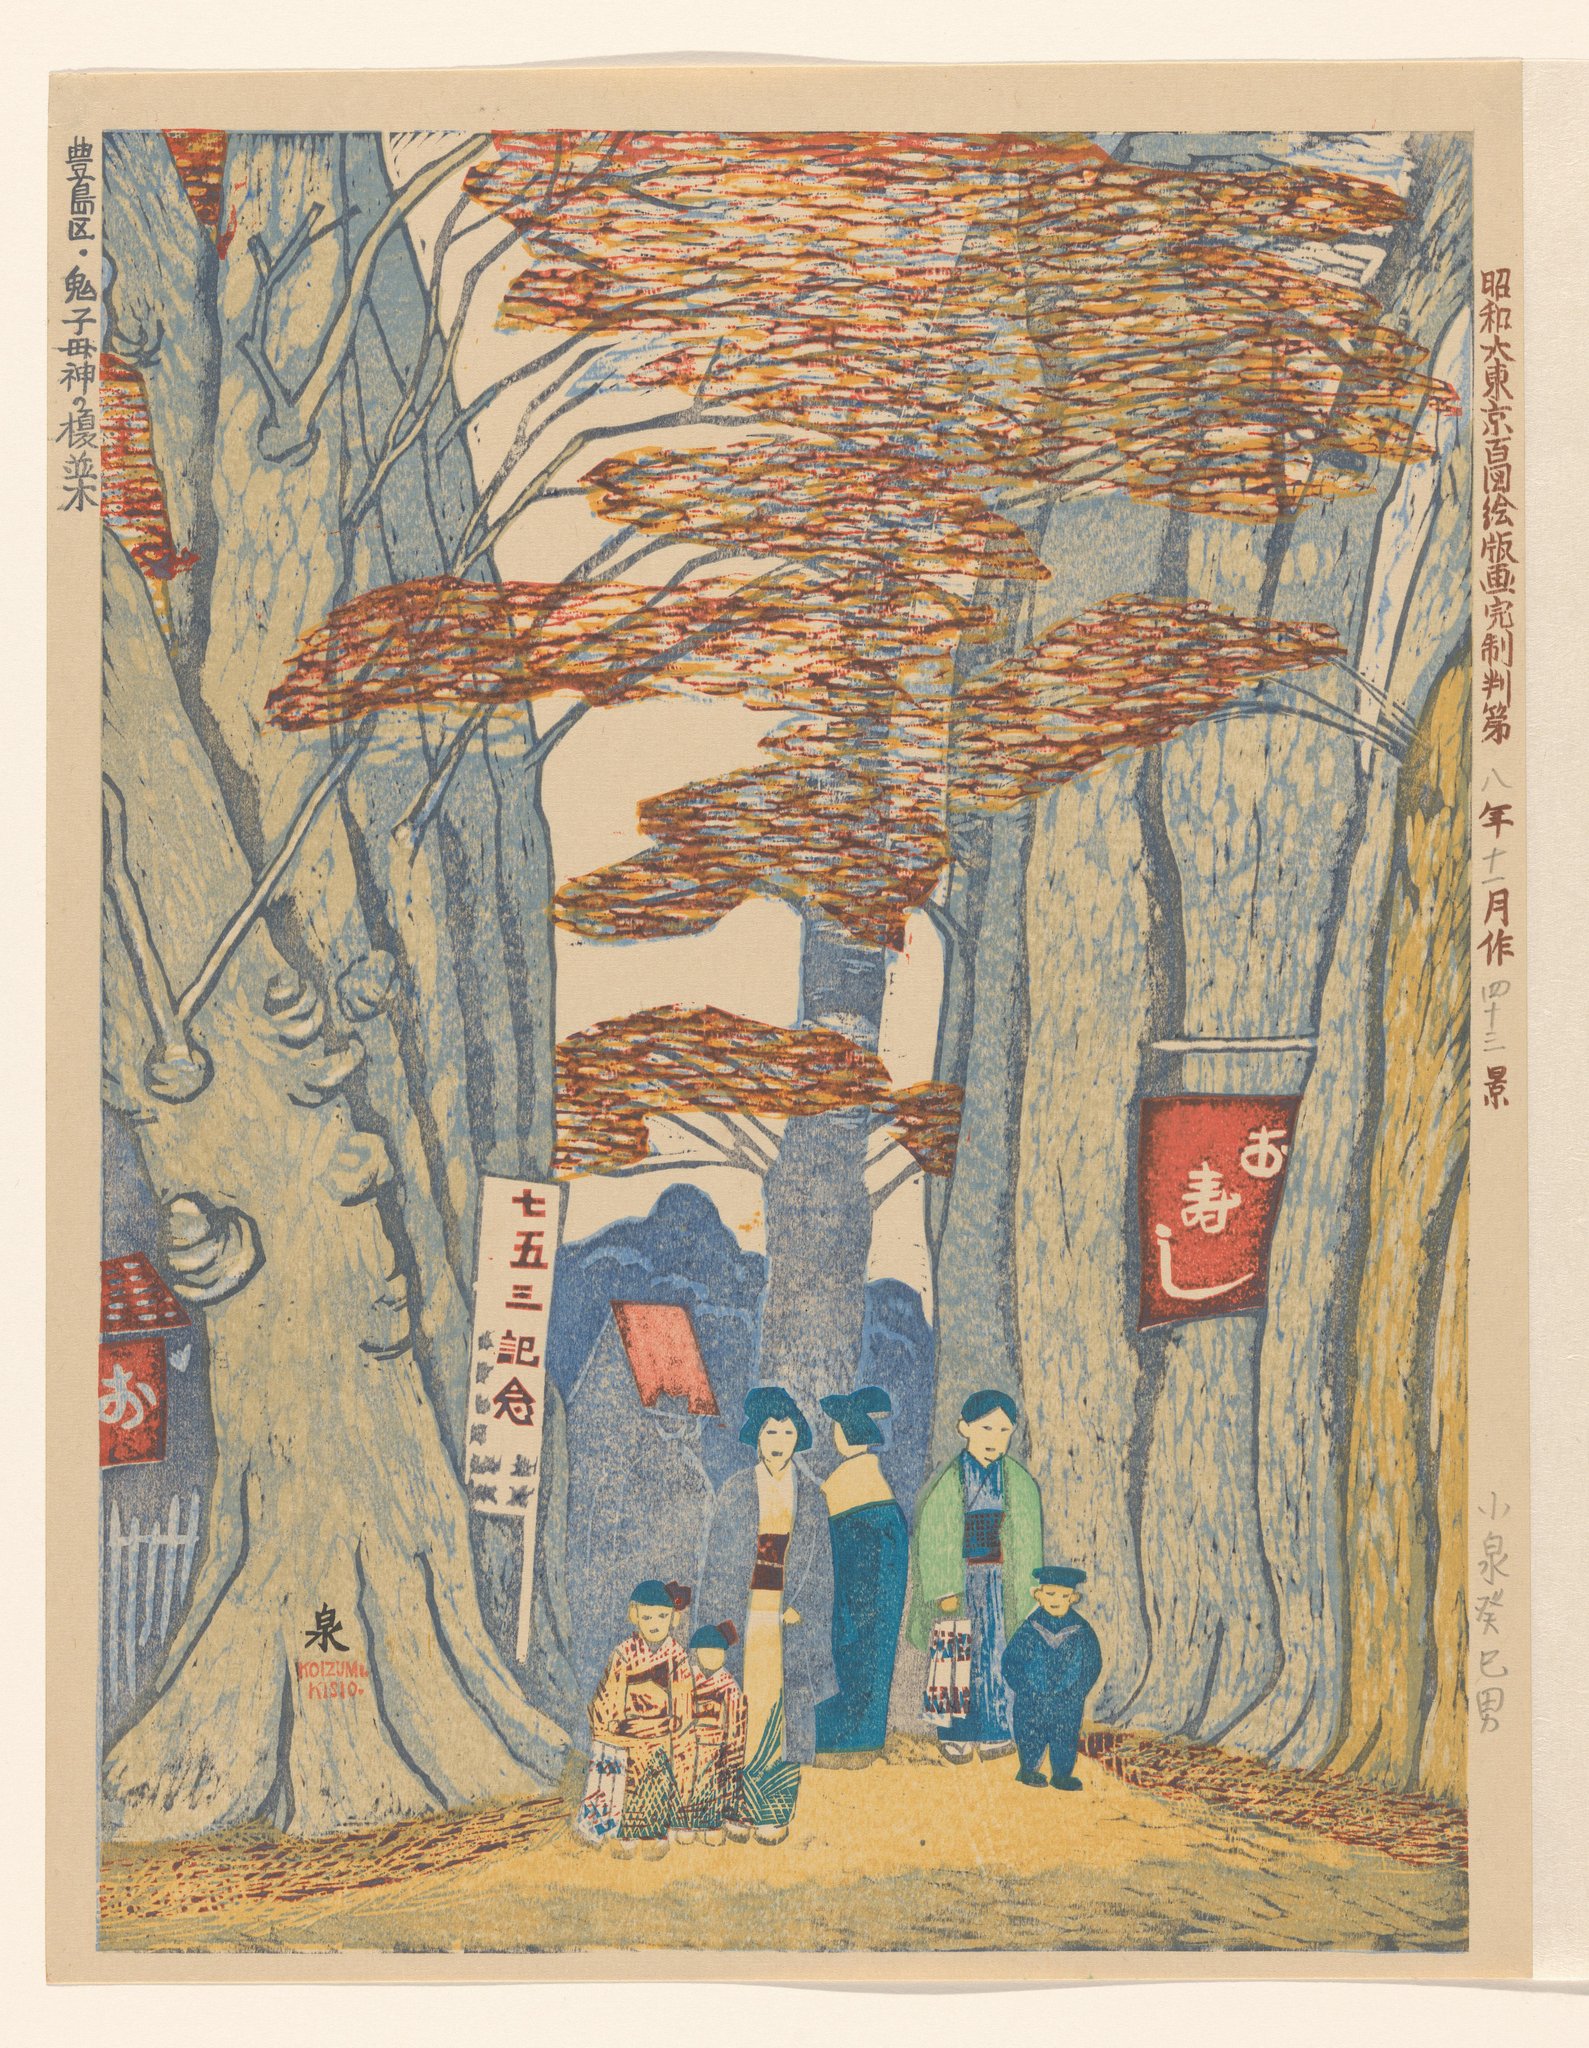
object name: print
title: Toshima-ku Kishimojin no namiki yonjūsankei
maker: koizumi kishio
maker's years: 1893-1945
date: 1911-1933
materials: paper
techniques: woodcut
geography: japan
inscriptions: signature: ‘泉’, signature: ‘小泉癸巳男’, seal: ‘Koizumi Kisio.’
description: Gele en oranje bladeren van grote loofbomen hangen hoog boven de hoofden van bezoekers aan het Kishimojin-heiligdom in Tokyo. Rechts hangt een rode banier die aangeeft dat er sushi wordt verkocht. De godheid Kishimojin is de beschermheilige van zwangerschap en kinderen. In september 1928 begon Koizumi Kishio aan zijn ambitieuze plan om honderd landschapsprenten met scènes in Tokyo volledig zelf te ontwerpen, hiervan zelf de drukblokken te snijden en zelf de prenten te drukken. De aanleiding voor het project was grote verandering die Tokyo onderging door de verwoestende Grote Kantō-aardbeving van 1923 en de wederopbouw die daarop volgde. Kishio maakt een bewuste verwijzing naar de bekende serie ‘Honderd beroemde gezichten op Edo’ door Utagawa Hiroshige (1797–1858), met prenten van locaties in Edo—de oude benaming voor Tokyo. Kishio toont overwegend moderne gebouwen, instituten en mensen die de tijdsgeest van de jaren 1920 en 1930 weerspiegelen. Sommige prenten onthullen daarentegen een nostalgische blik op overblijfselen uit het oude Edo. Kishio verkocht de prenten aan de hand van een abonnement met een limiet van vijftig leden, die elke maand een of twee prenten zouden ontvangen. Het project begon met negen abonnementen, maar al na de tweede maand werden meerdere daarvan opgezegd en slechts vier mecenassen bleven lid tot en met de voltooiing van de serie. Hij bracht het honderdste ontwerp uit in 1937. Zijn leermeester Ishii Hakutei schreef een inleiding in 1938 die Kishio verwerkte tot een prent en toevoegde aan de set. Tussen 1939 en 1940 maakte hij nog eens negen extra ontwerpen. Met acht van deze ontwerpen verving hij oudere nummers uit de serie, mogelijk omdat hij niet tevreden was met de composities. Uiteindelijk lukte het Kishio om tien complete sets te verkopen aan de shin hanga-uitgever Watanabe Shōzaburō en liet hiervoor speciale houten dozen maken. Deze prent behoort tot een van die tien sets.